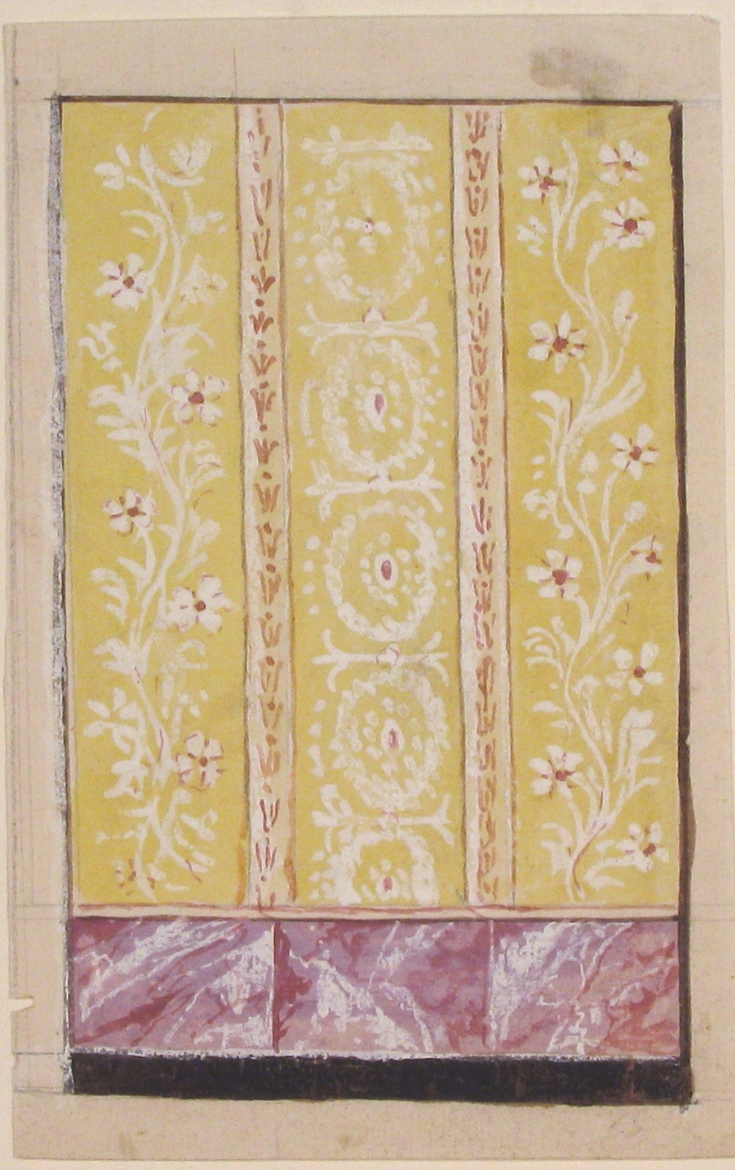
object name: drawing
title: Design for Wall Panel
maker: anonymous, french, 18th century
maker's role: artist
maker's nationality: french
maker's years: 1700-1800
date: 1701-1800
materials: gouache, graphite, watercolor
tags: flowers